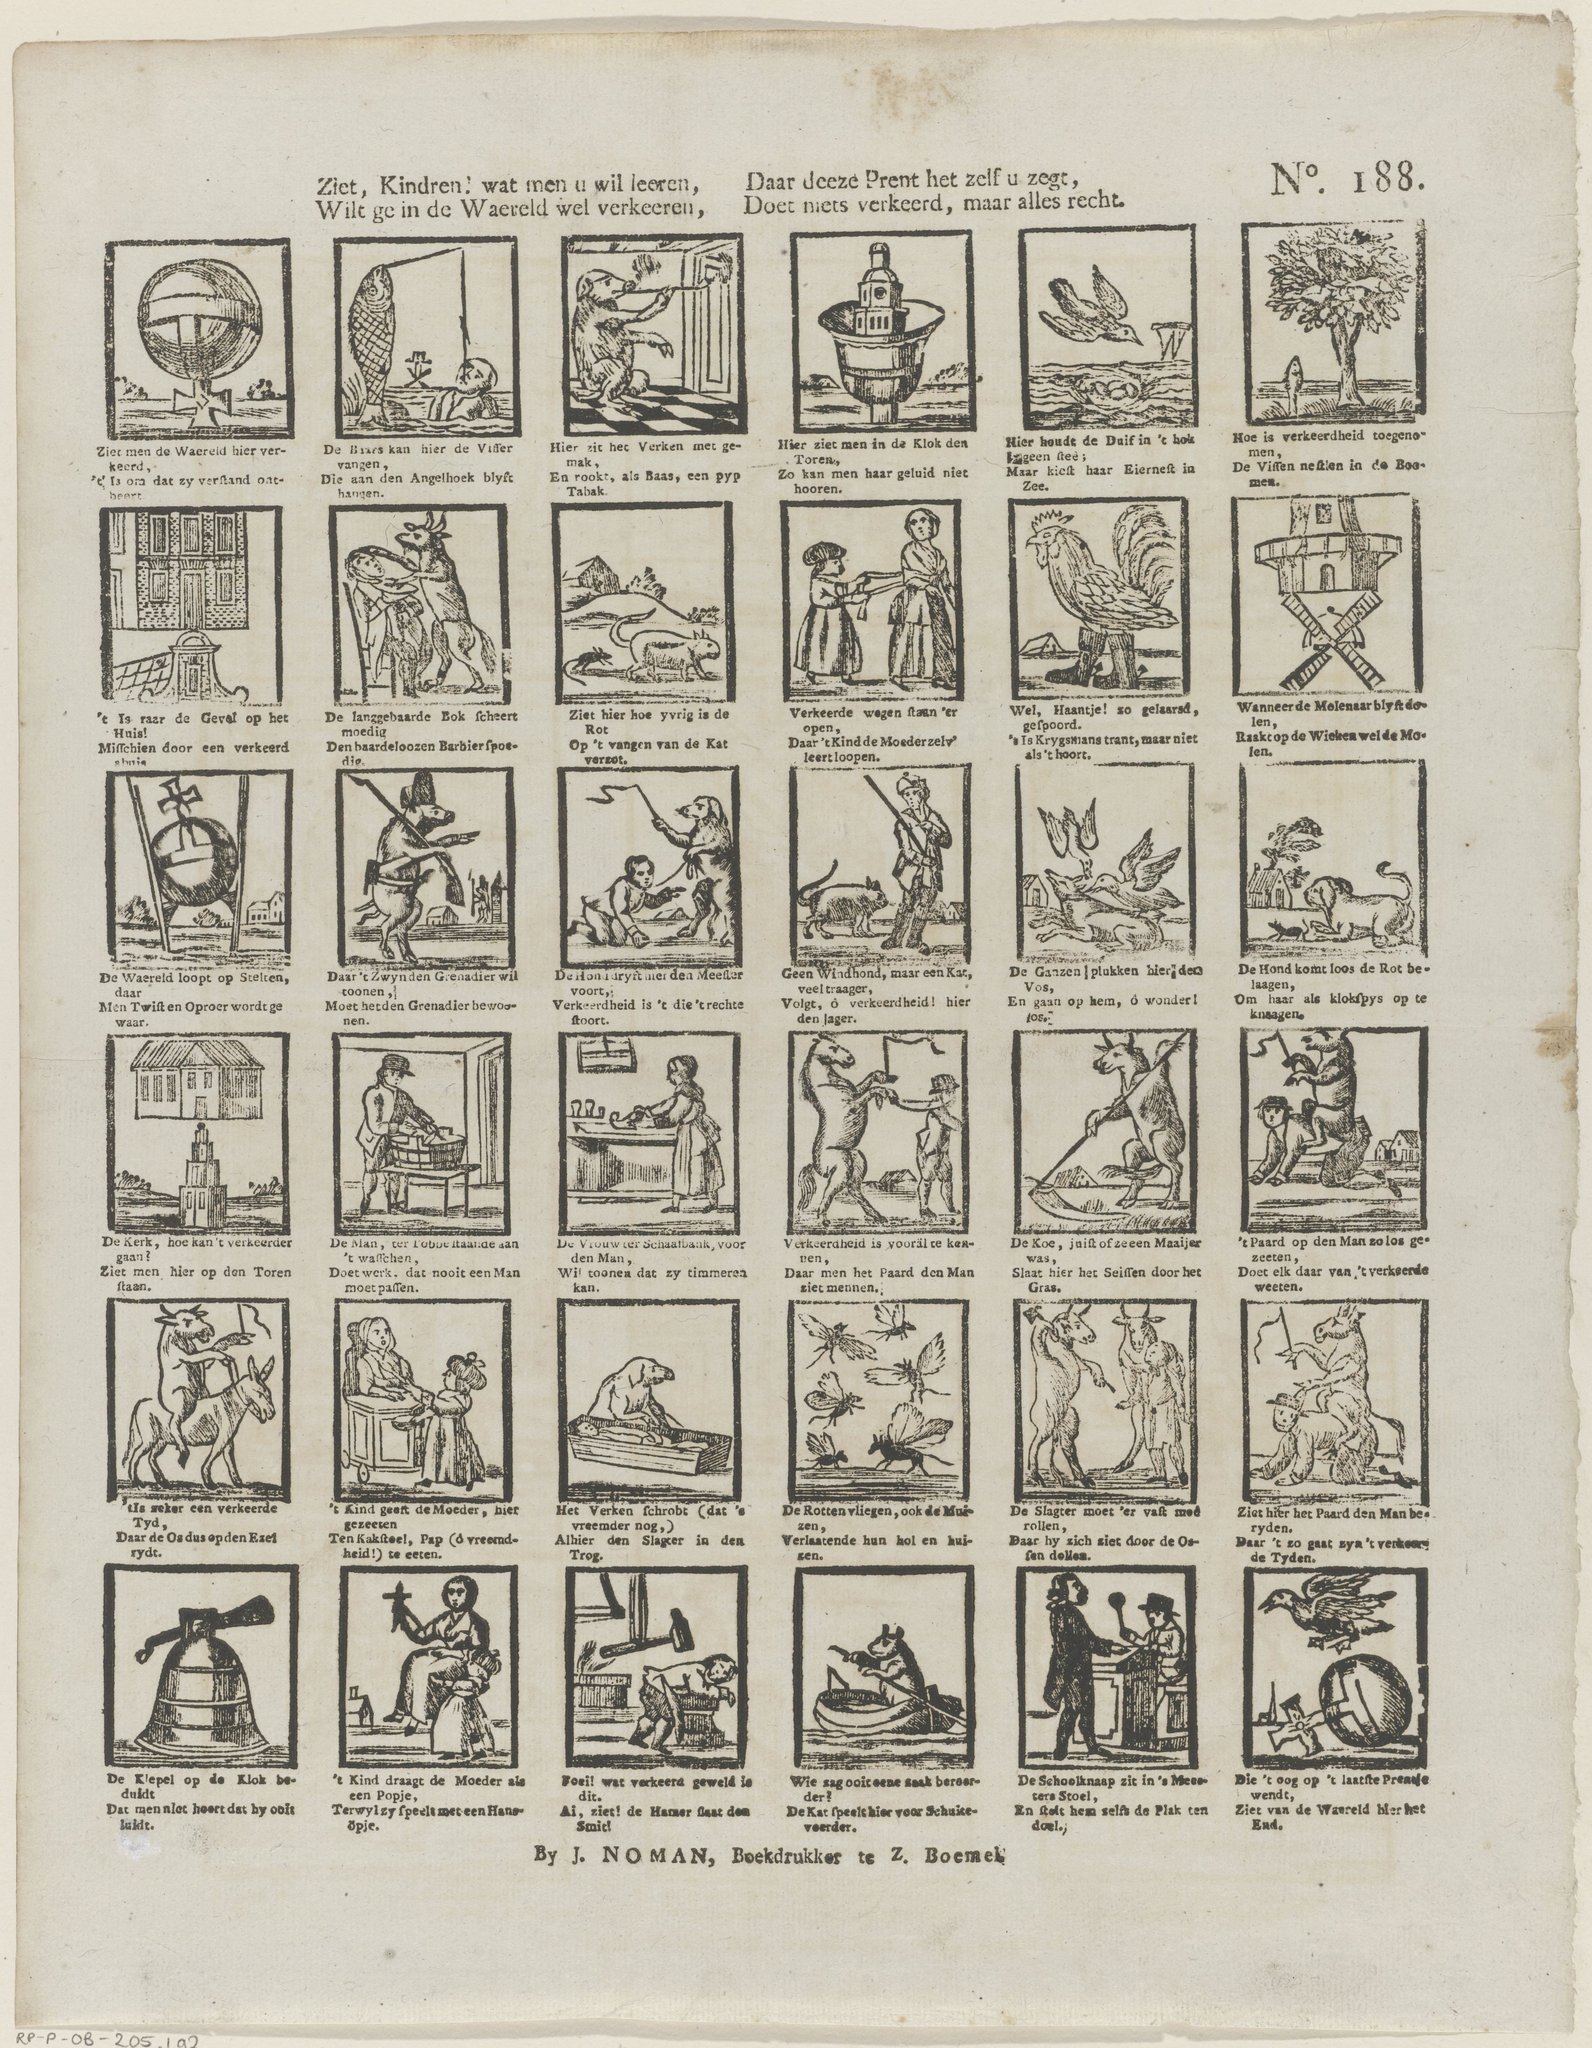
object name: print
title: Ziet, kindren! wat men u wil leeren, / Wilt ge in de waereld wel verkeeren, / Daar deeze prent het zelf u zegt, / Doet niets verkeerd, maar alles recht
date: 1806-1830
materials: paper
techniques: letterpress printing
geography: netherlands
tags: 'mundus inversus', the reversed world, the topsy-turvy world, 'le monde bestourné', animals acting as human beings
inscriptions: collector's mark: Lugt 2760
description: Blad met 36 voorstellingen van de verkeerde wereld, waar onder andere dieren zich als mensen gedragen. Onder elke afbeelding een tweeregelig vers. Genummerd rechtsboven: No. 188.